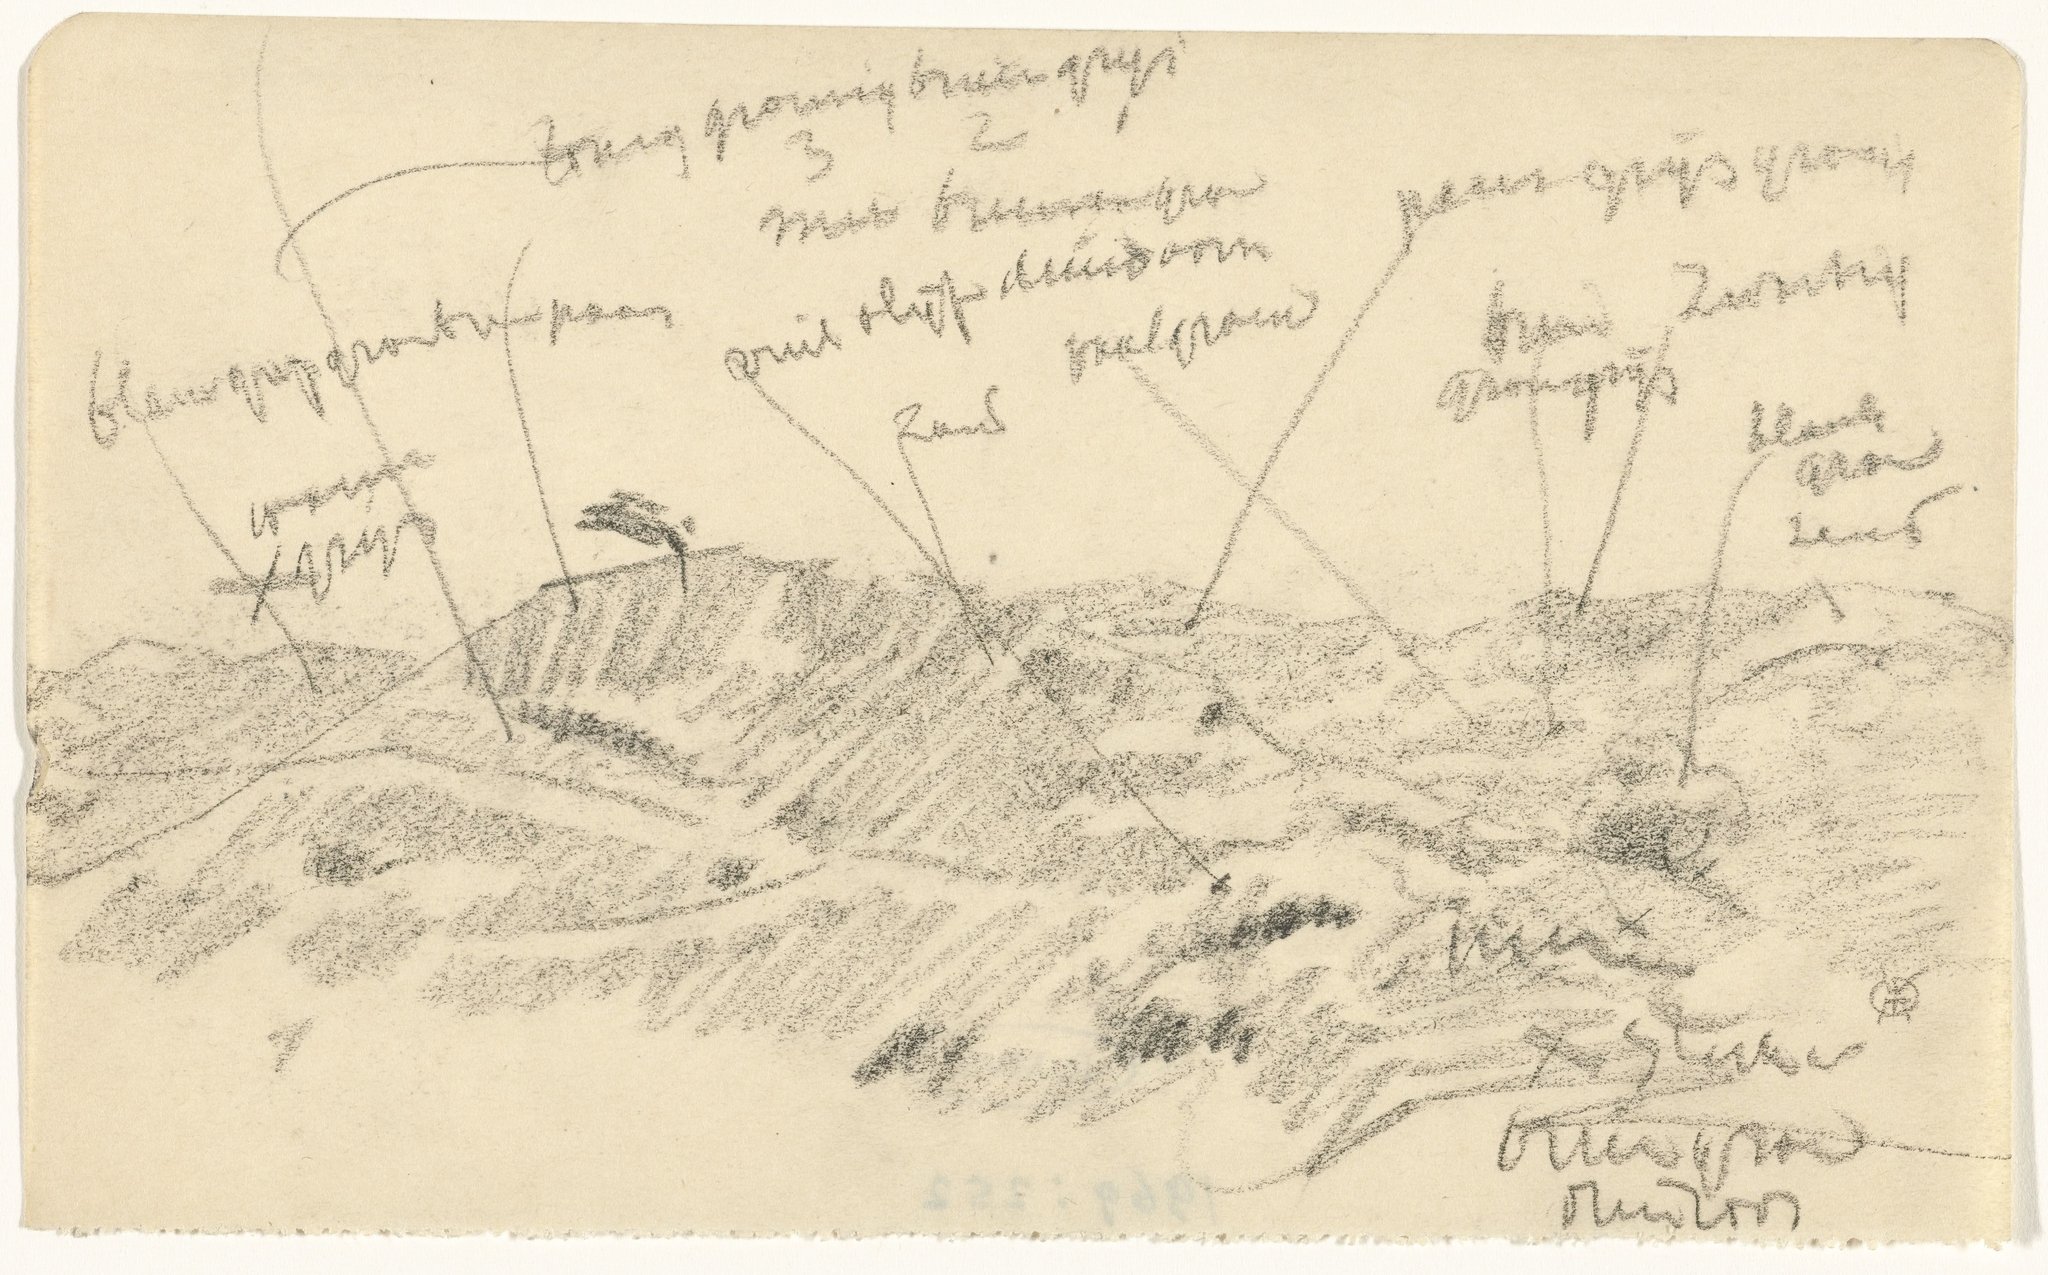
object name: drawing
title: Gezicht in de duinen, met kleurnotities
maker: gerrit willem dijsselhof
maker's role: designer, draughtsman, print maker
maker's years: 1866-1924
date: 1876-1924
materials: chalk, paper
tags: dunes (sea not visible); in the dunes